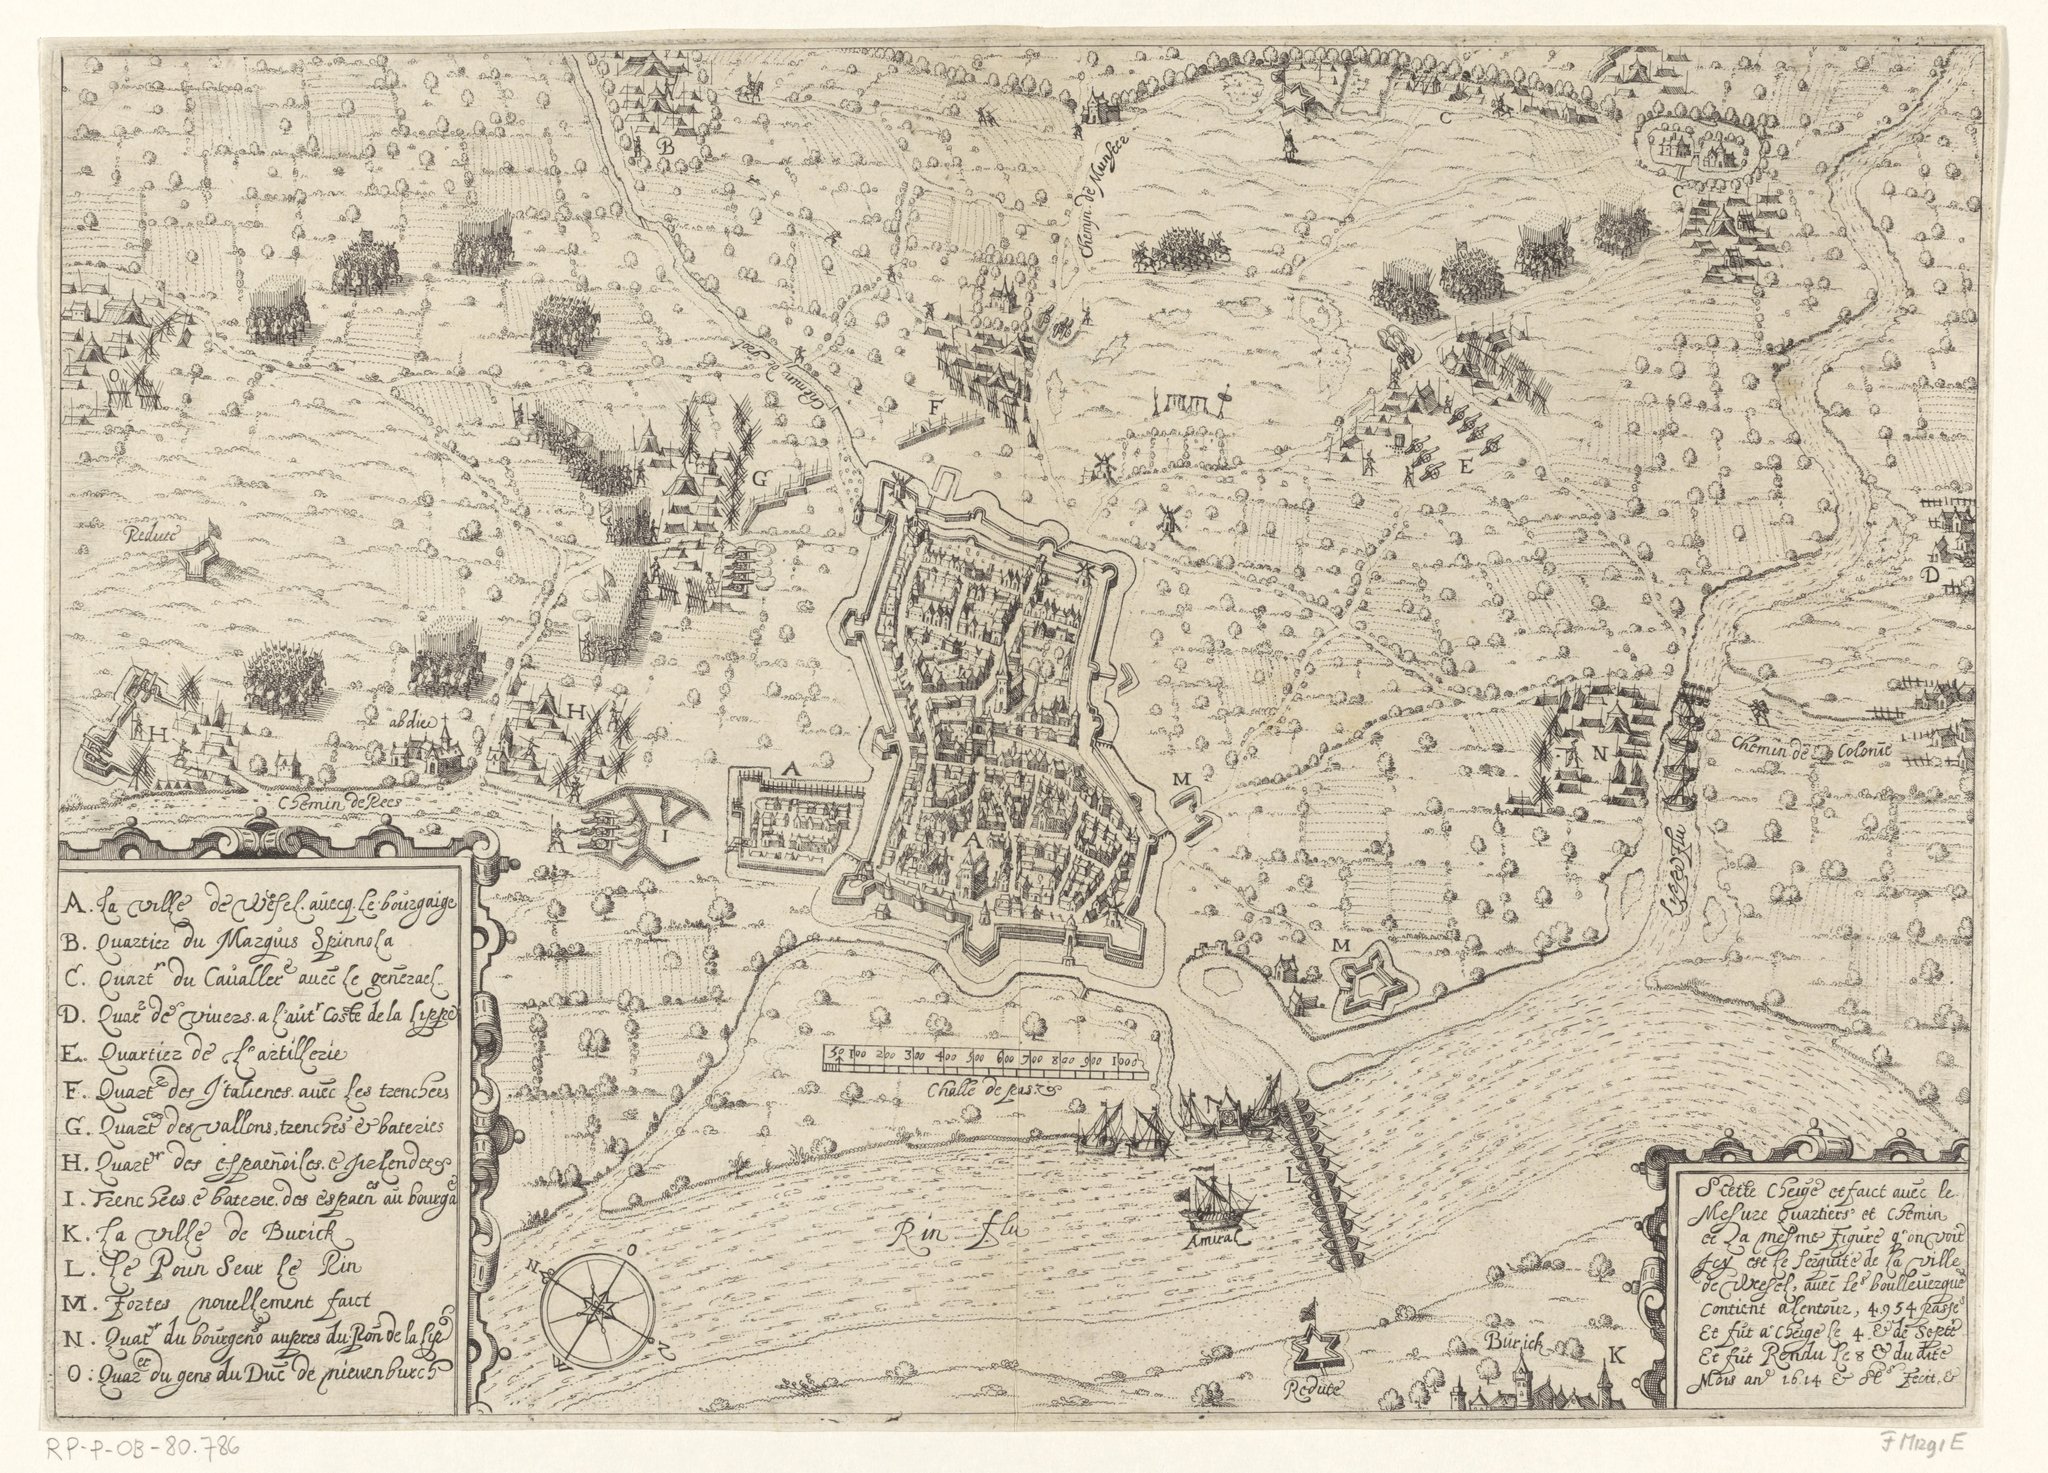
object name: print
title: Beleg en inname van Wesel door Spinola, 1614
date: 1614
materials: paper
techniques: etching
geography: france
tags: maps of separate countries or regions, siege, position war, capture of city (after the siege)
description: Beleg en inname van Wesel door het Spaanse leger onder Spinola, 4-8 september 1614. Plan op de stad en het omliggende land aan de Rijn, met de legerkampen van de belegeraars. Rechts en links onderaan twee cartouches met de legenda A-O en een opschrift in het Frans.